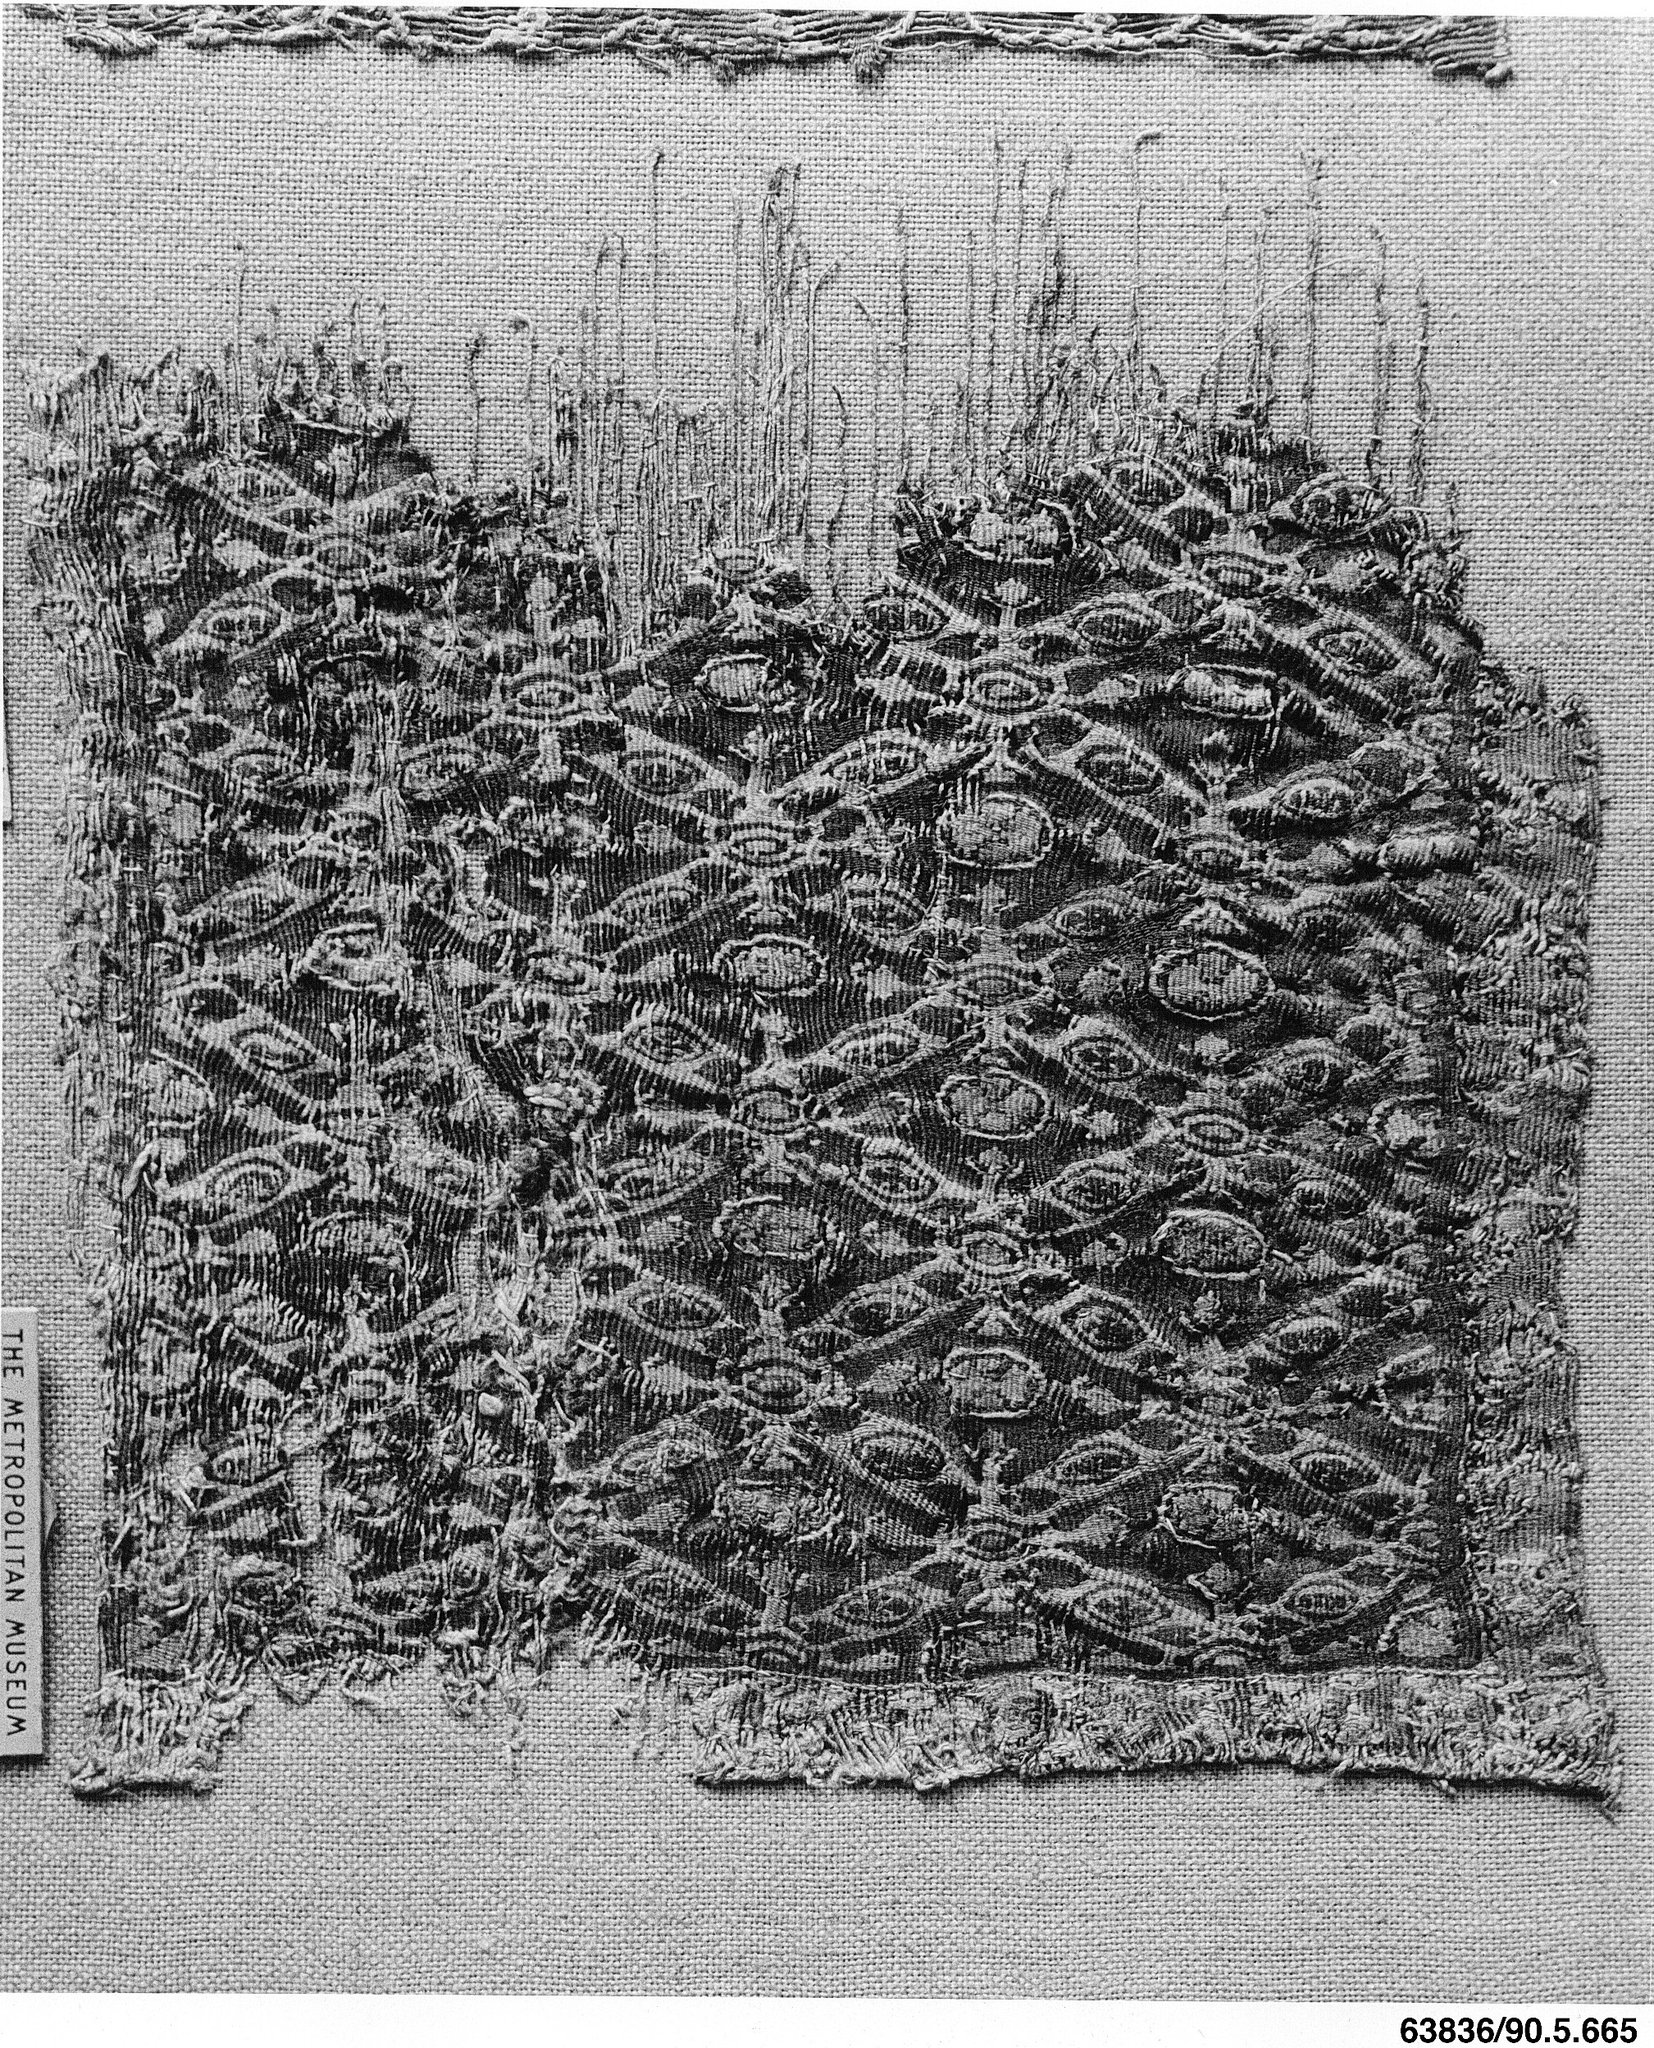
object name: textile fragment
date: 501-700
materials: linen, wool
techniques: weave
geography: egypt